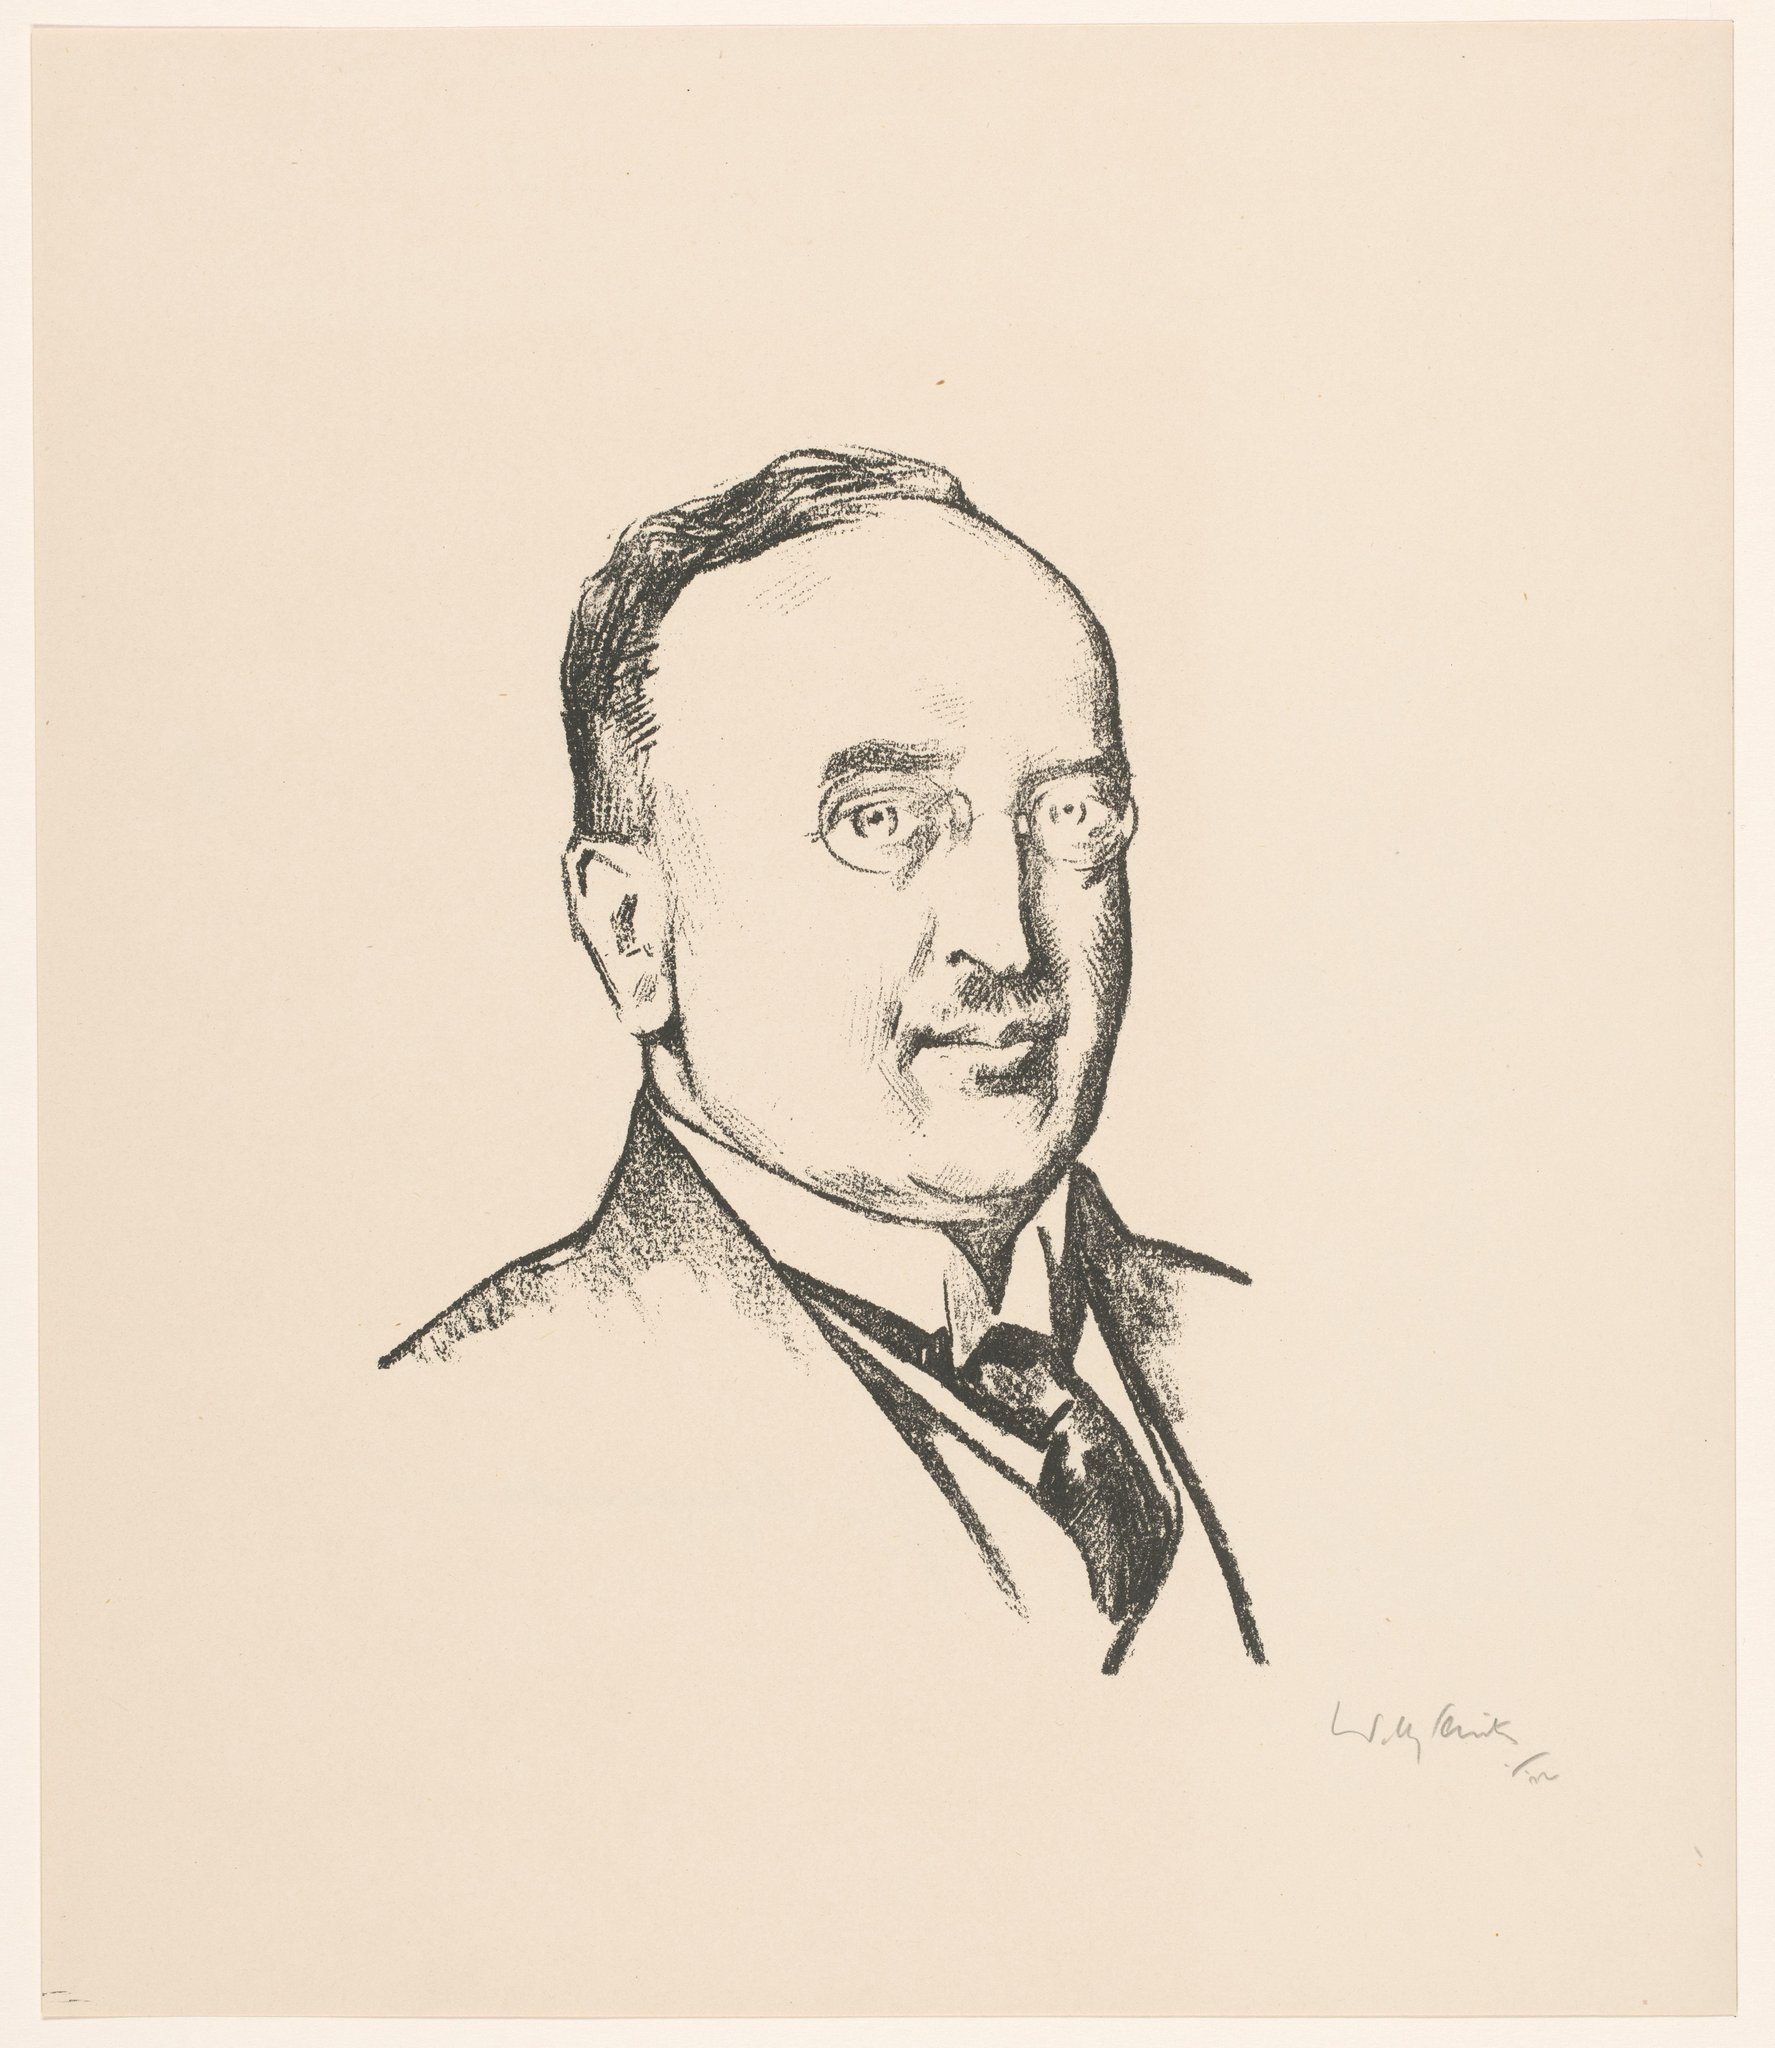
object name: print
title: Portret van Hendrik Gerrit van Wijngaarden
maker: willy sluiter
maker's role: draughtsman, painter, print maker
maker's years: 1873-1949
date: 1922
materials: paper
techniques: lithograph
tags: utrecht, historical persons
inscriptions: collector's mark: Lugt 2228